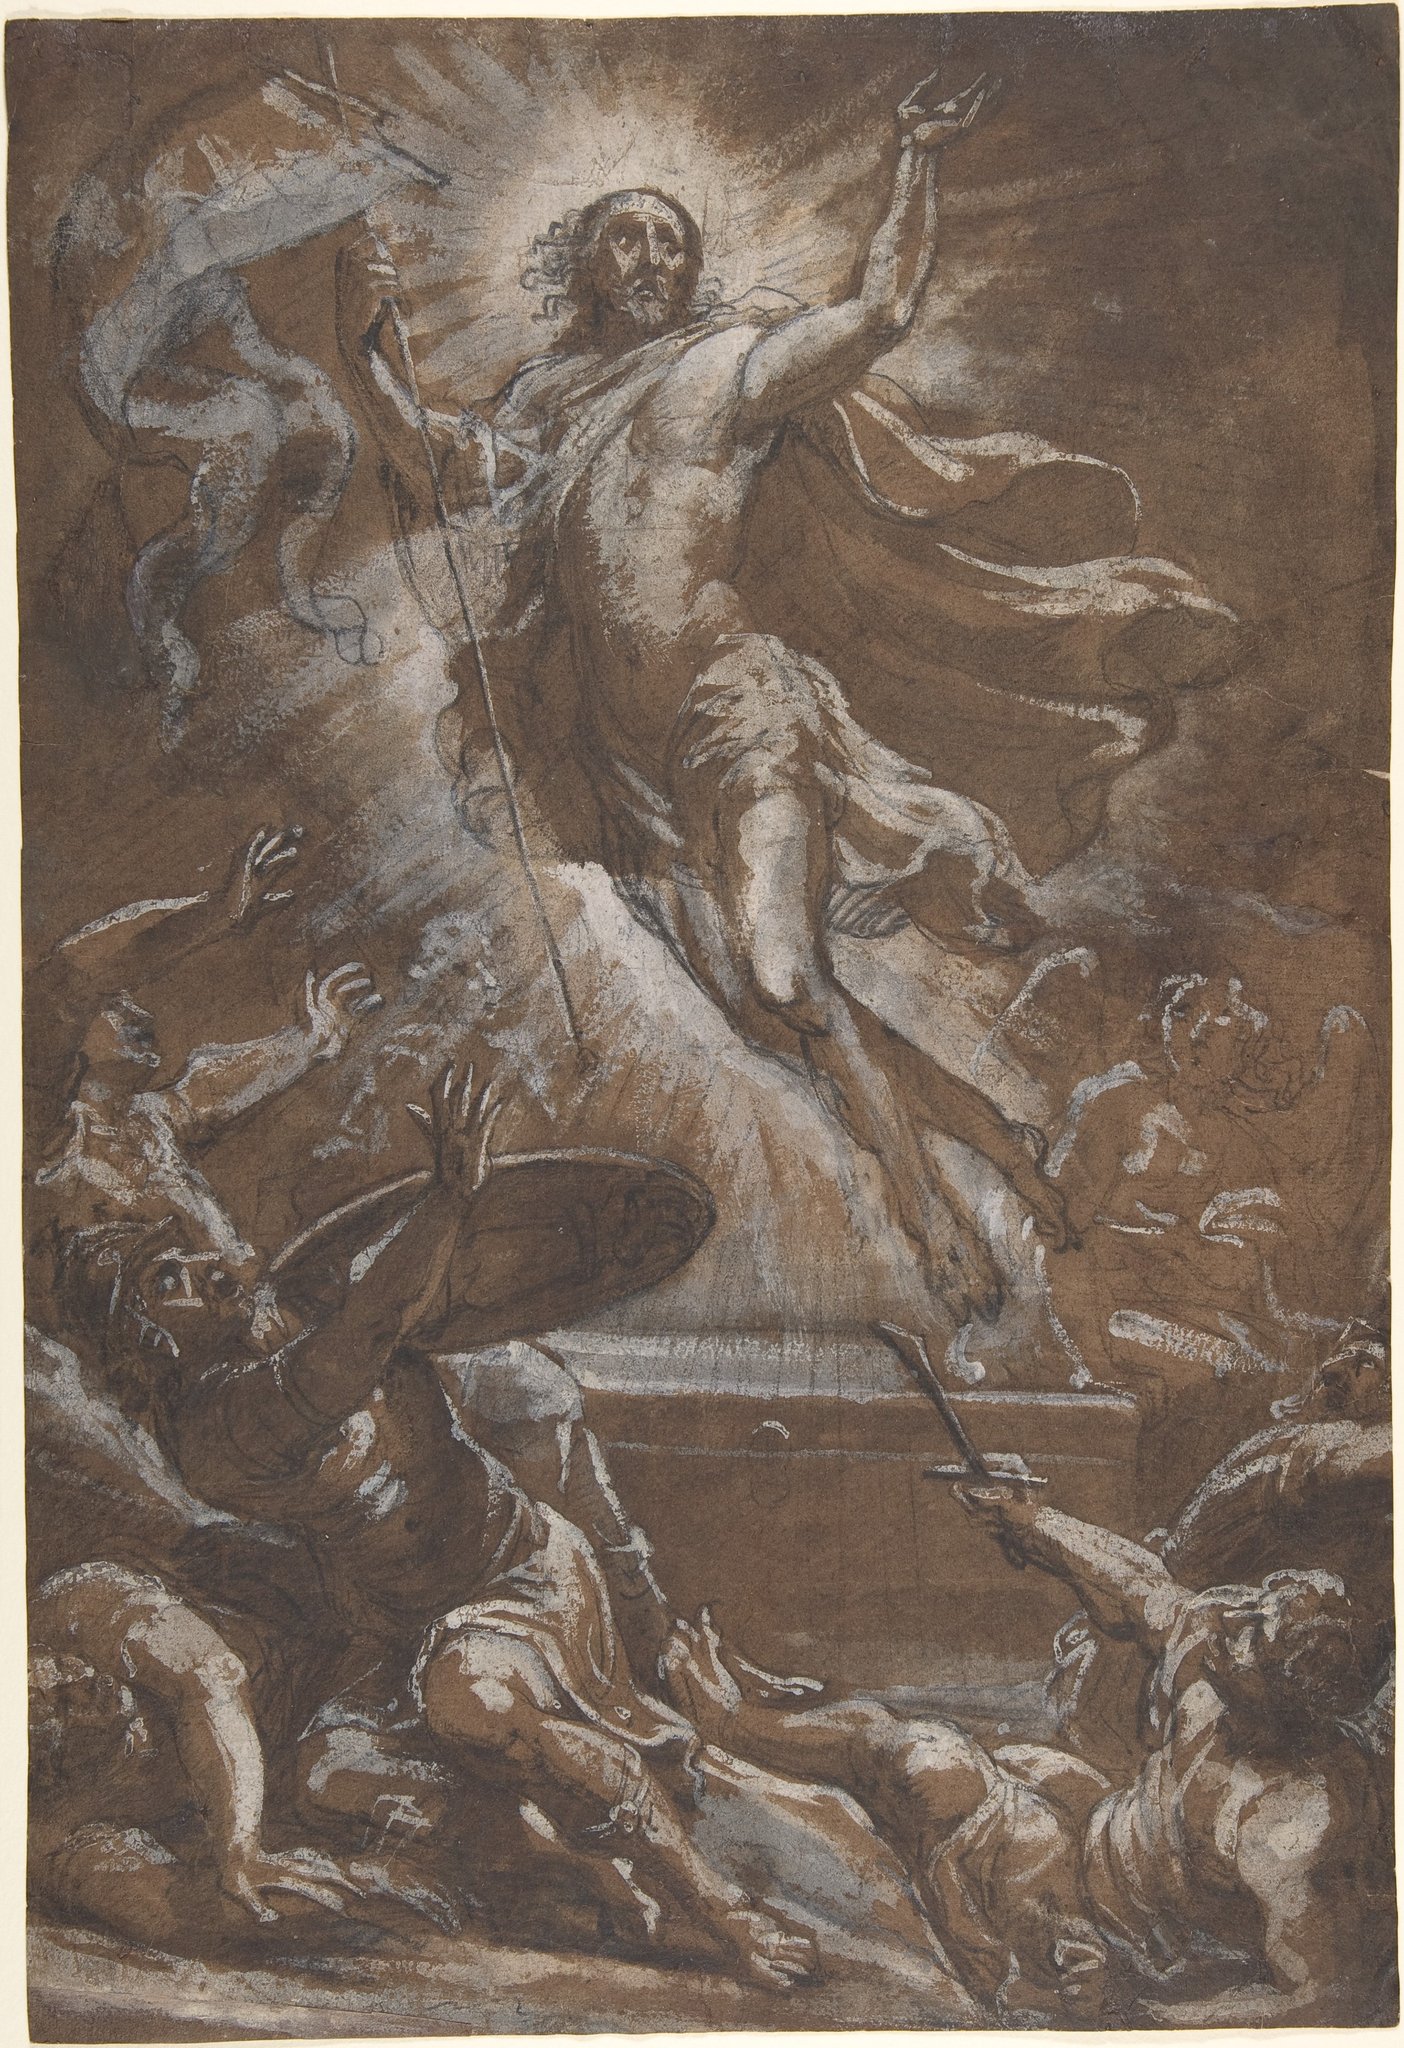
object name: drawing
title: The Resurrection of Christ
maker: denijs calvaert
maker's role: artist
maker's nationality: netherlandish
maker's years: 1540-1619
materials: chalk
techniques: heightening, wash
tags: weapons,men,christ